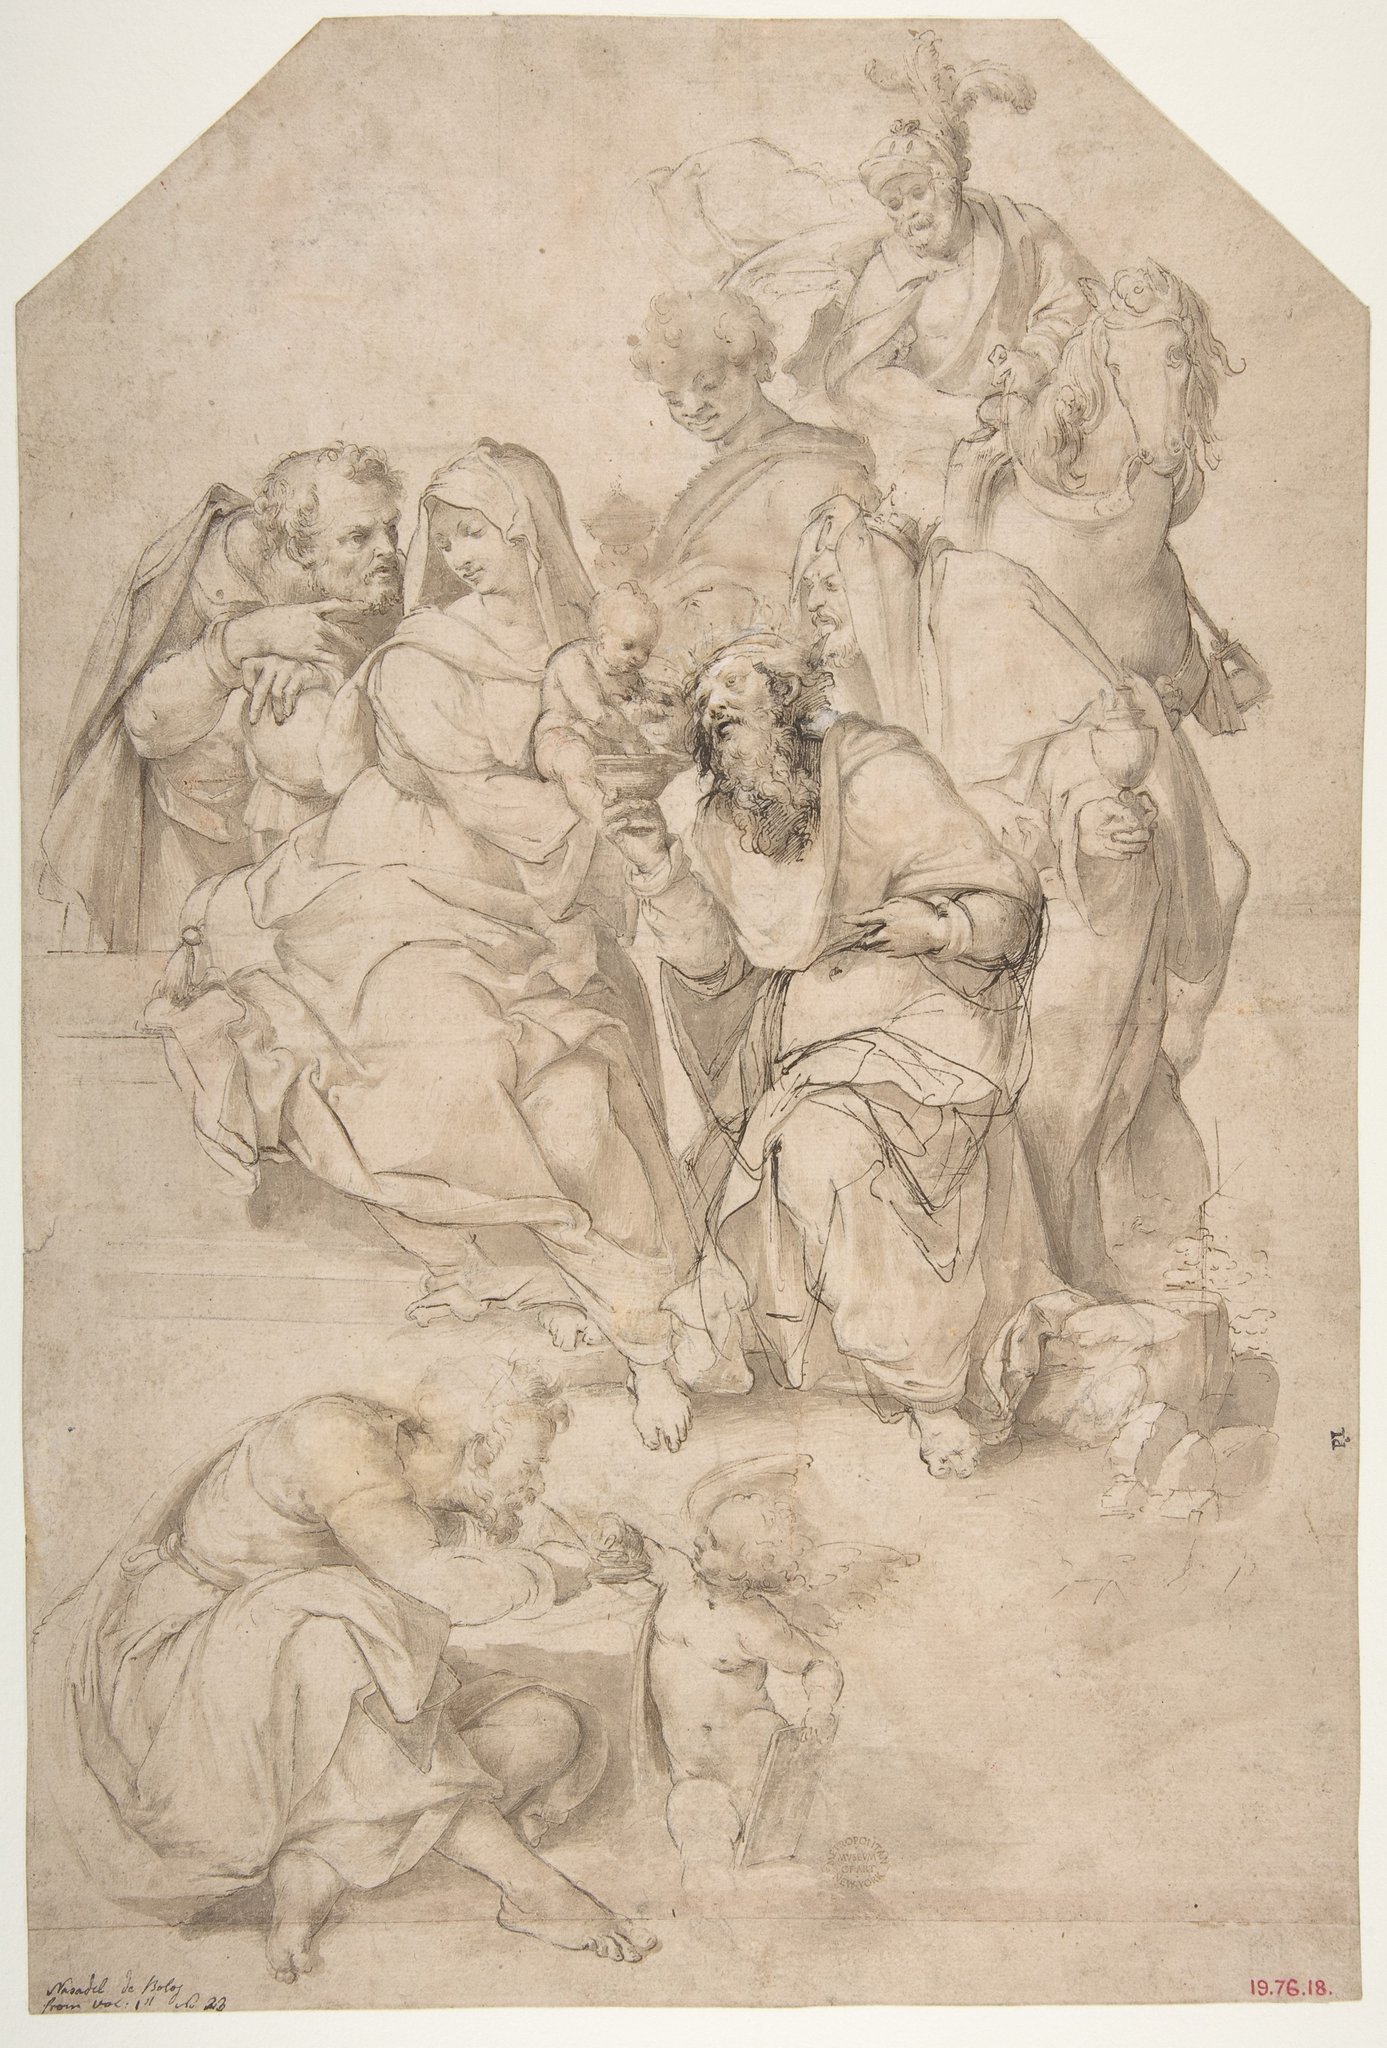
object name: drawing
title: The Adoration of the Magi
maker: nosadella (giovanni francesco bezzi)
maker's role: artist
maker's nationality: italian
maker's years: 1500-1571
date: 1500-1571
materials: chalk, gouache, ink, paper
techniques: brush, highlighting, pen, wash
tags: adoration of the magi